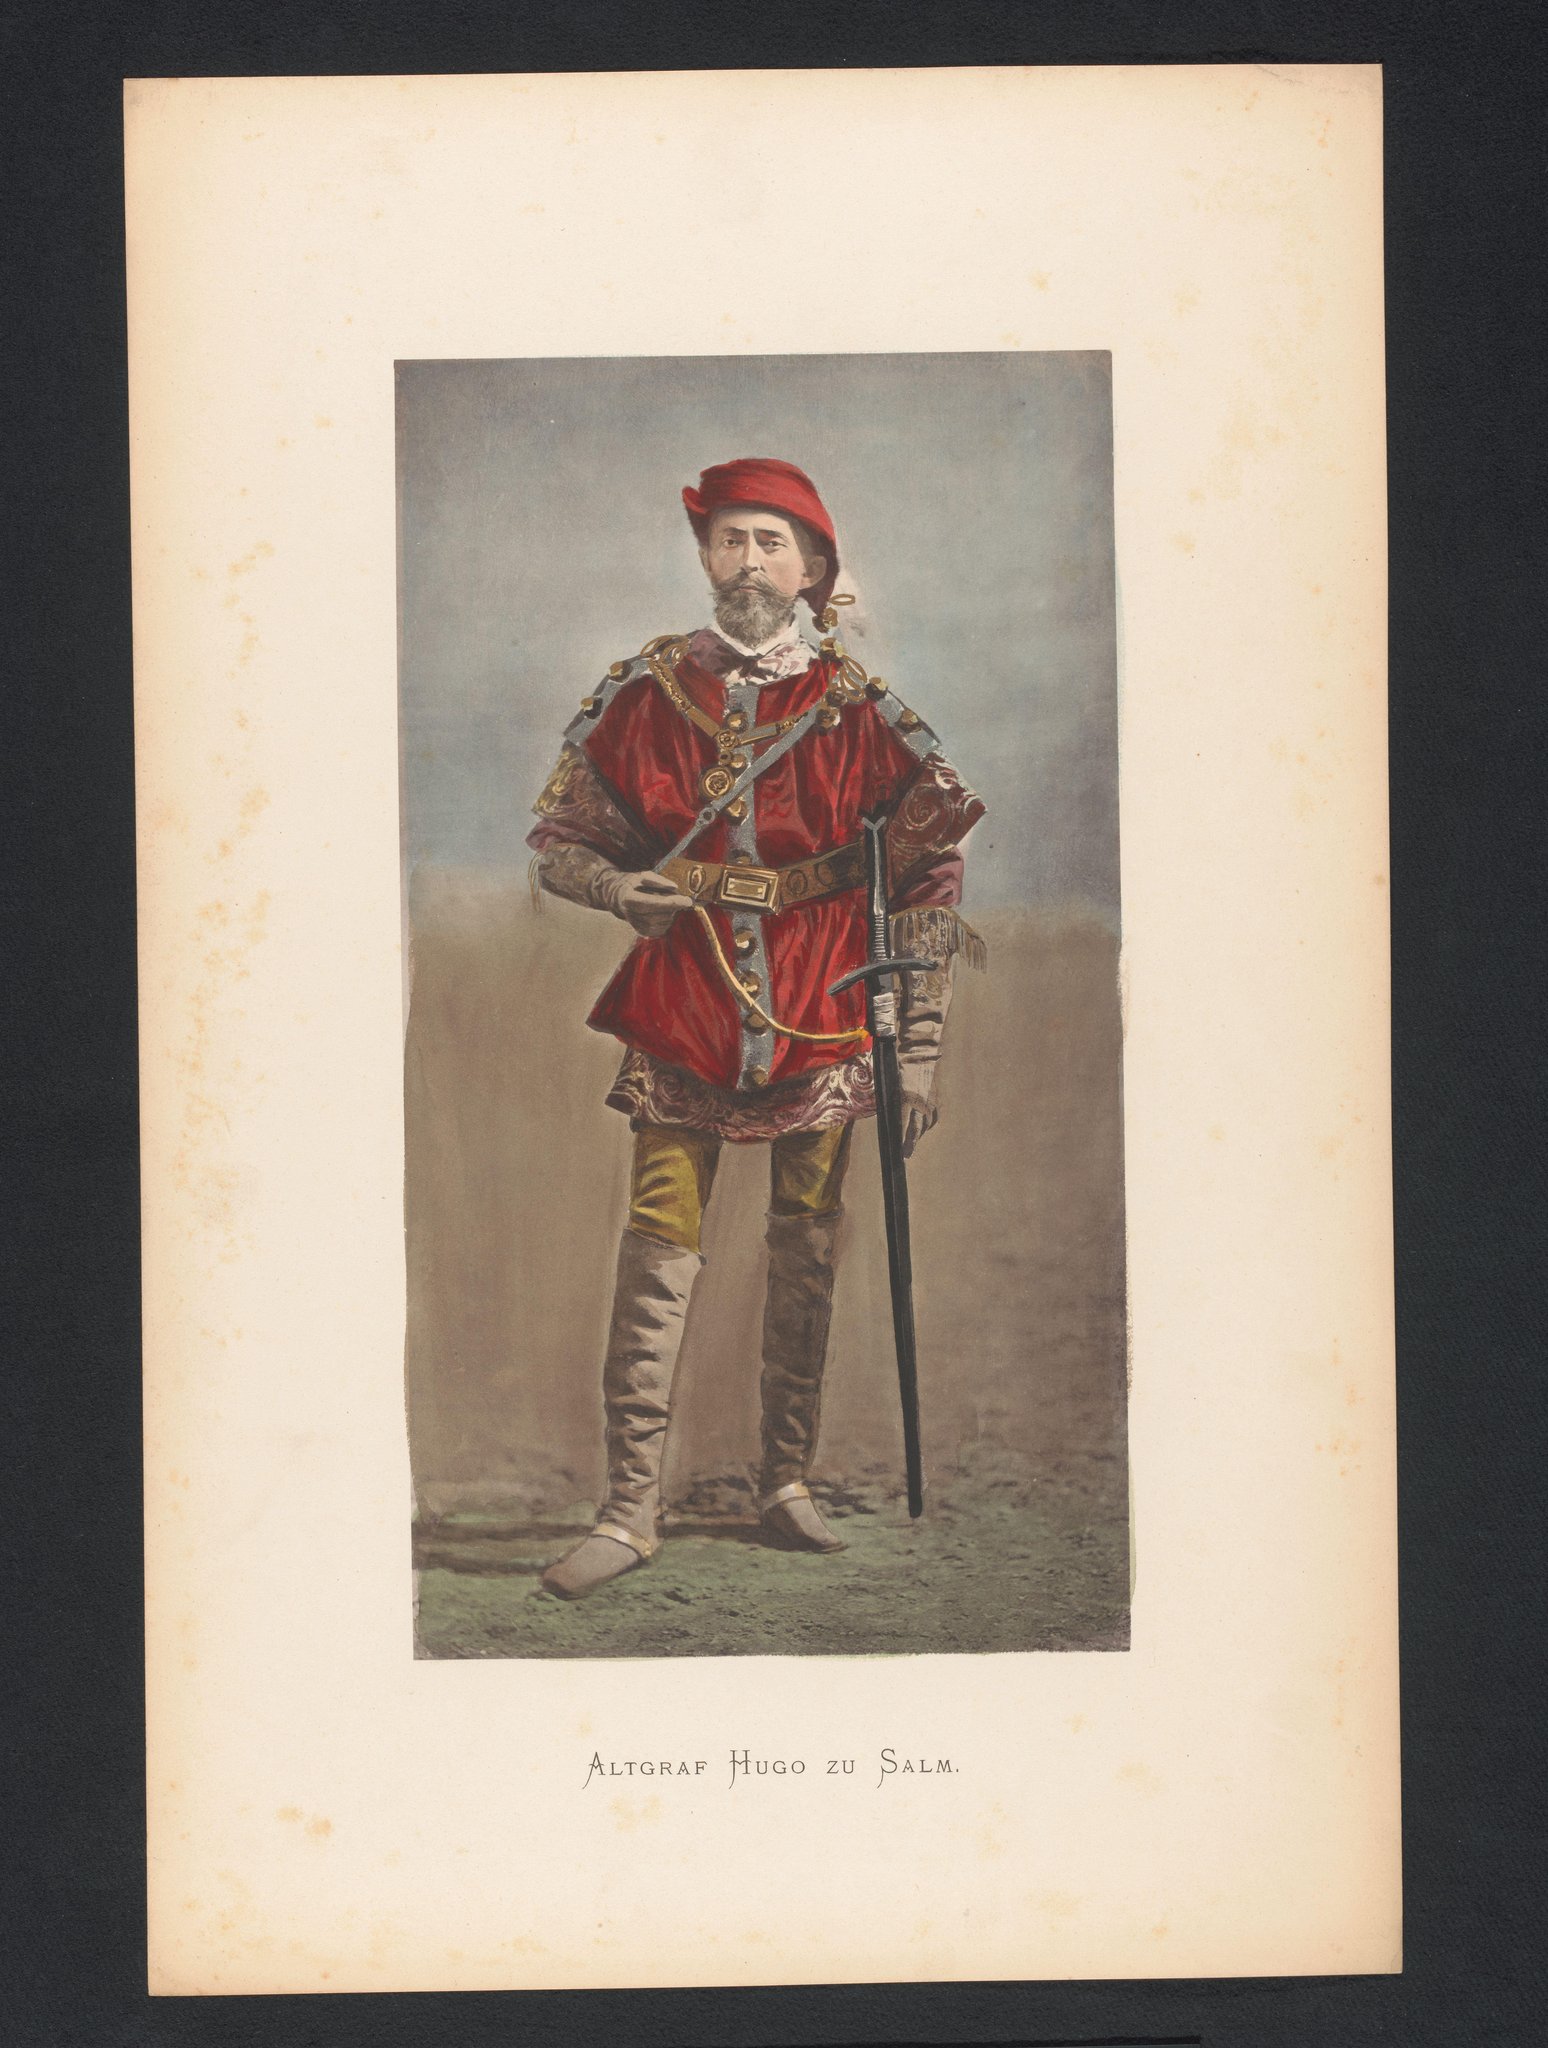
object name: photomechanical print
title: Altgraf Hugo zu Salm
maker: Anonymous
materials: paper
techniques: photograph, hand coloring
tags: vienna, aristocracy; 'aristocratia' (ripa), historical persons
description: Deze prent maakt deel uit van een omslag met 86 prenten op 78 bladen en 11 tekstbladen.